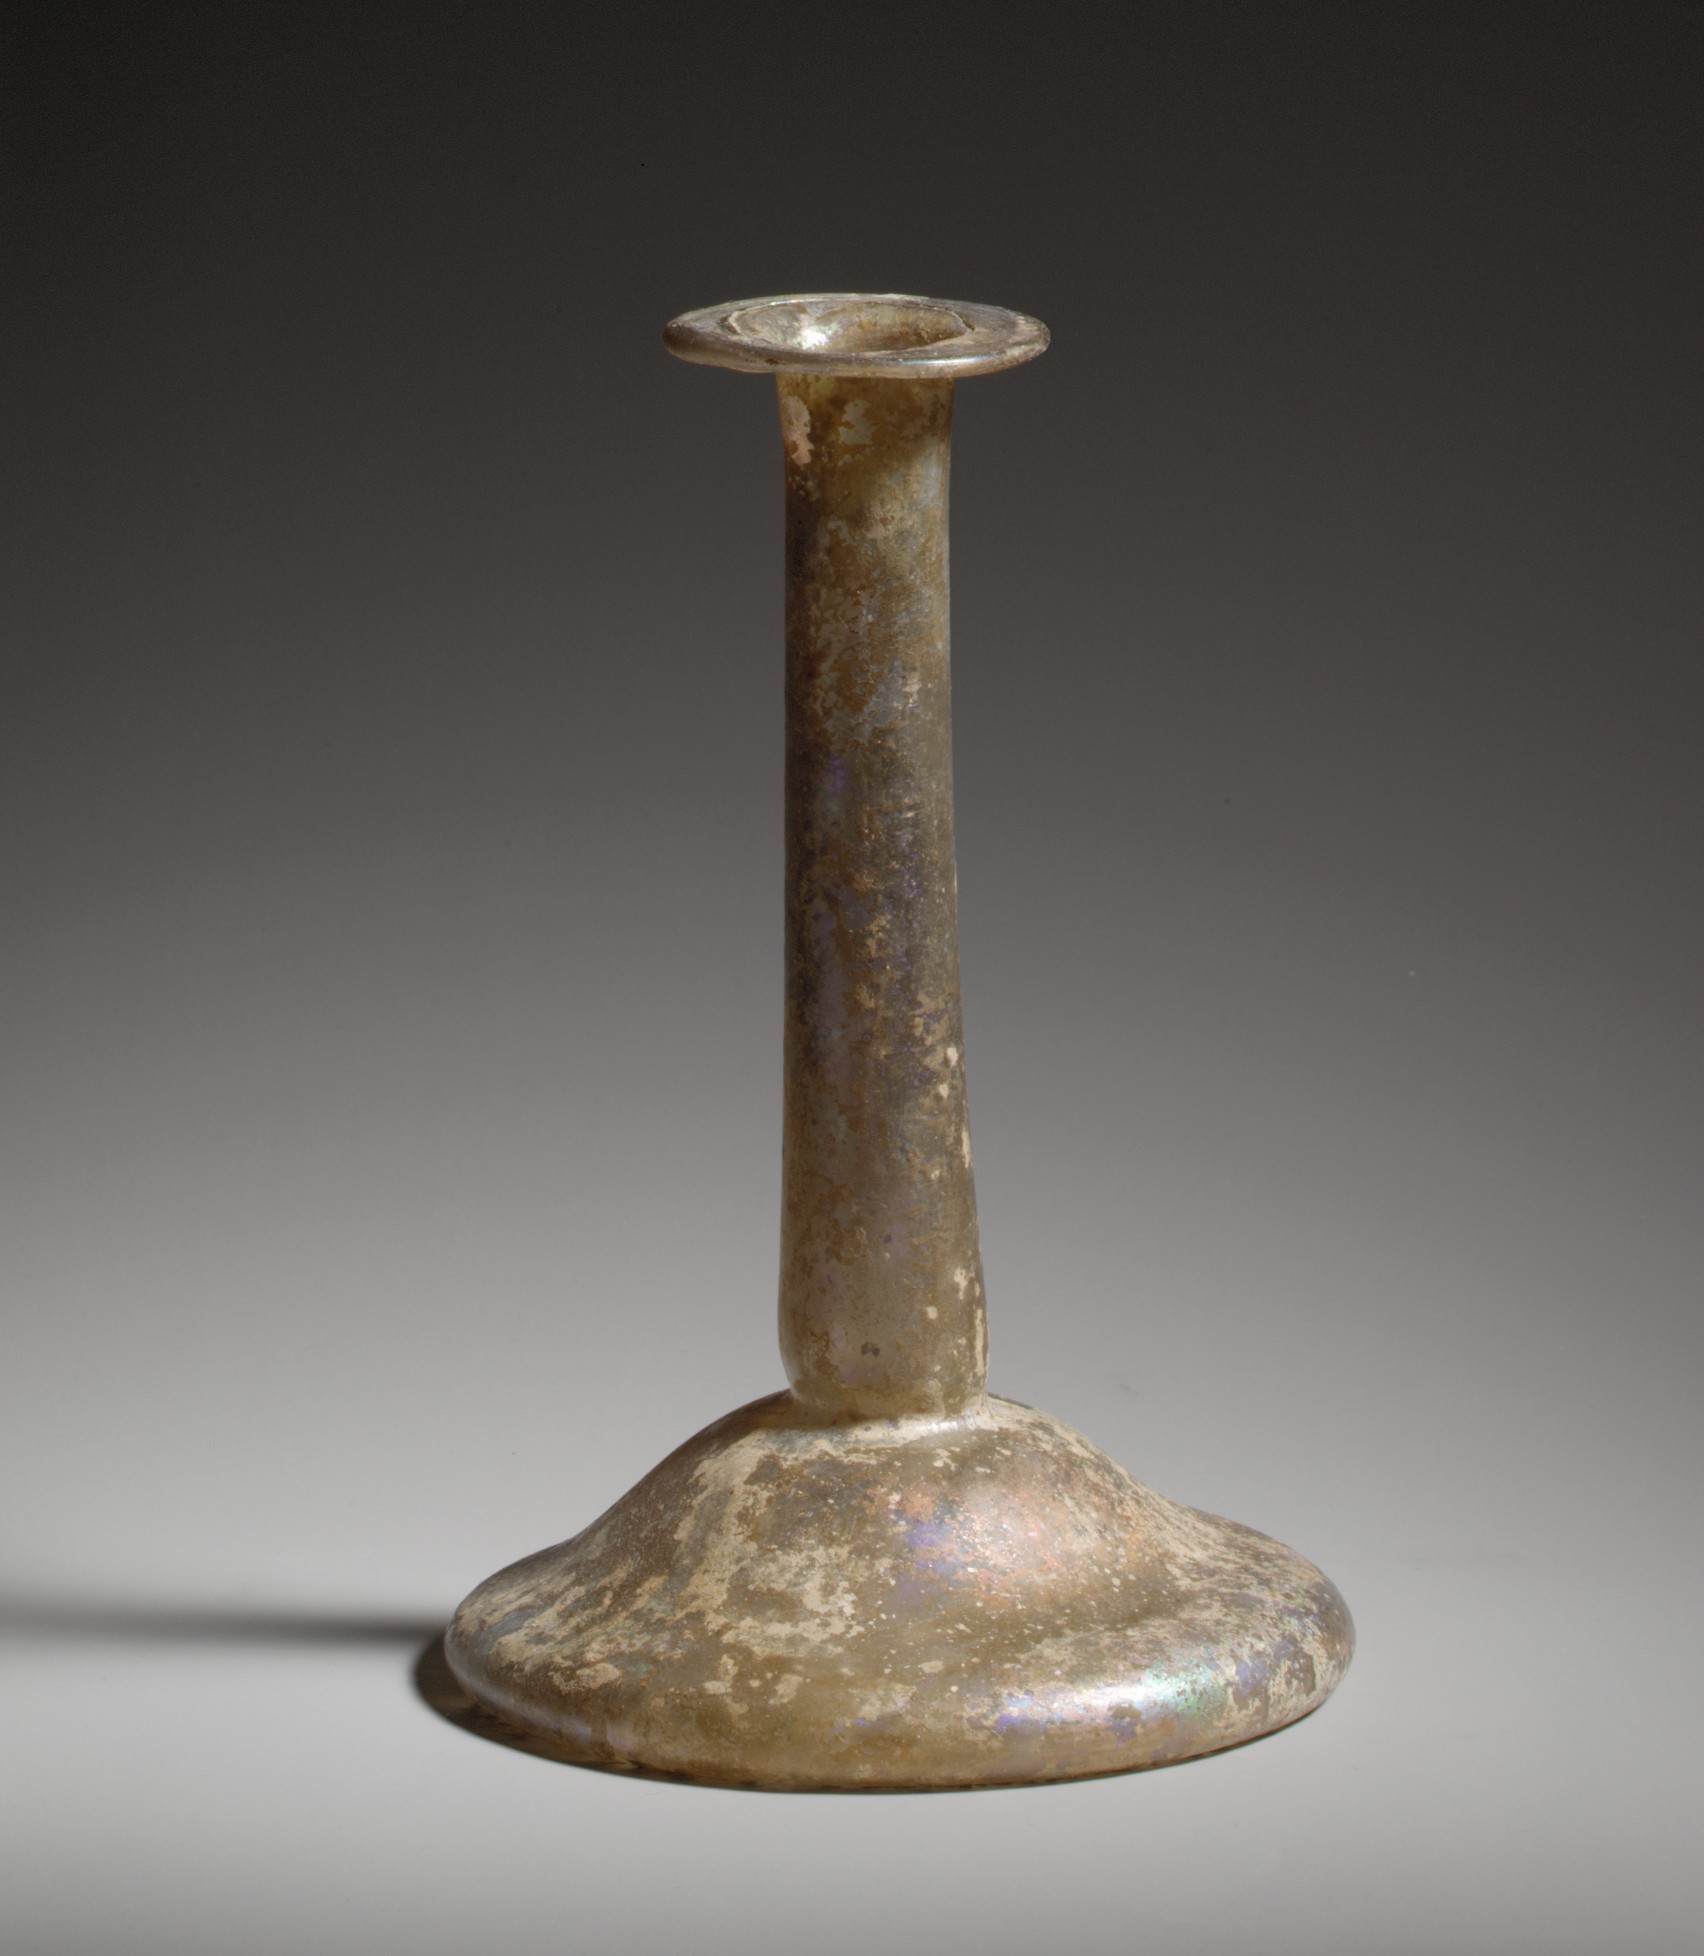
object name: candlestick perfume bottle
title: Glass perfume bottle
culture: roman, cypriot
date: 101-300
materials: glass